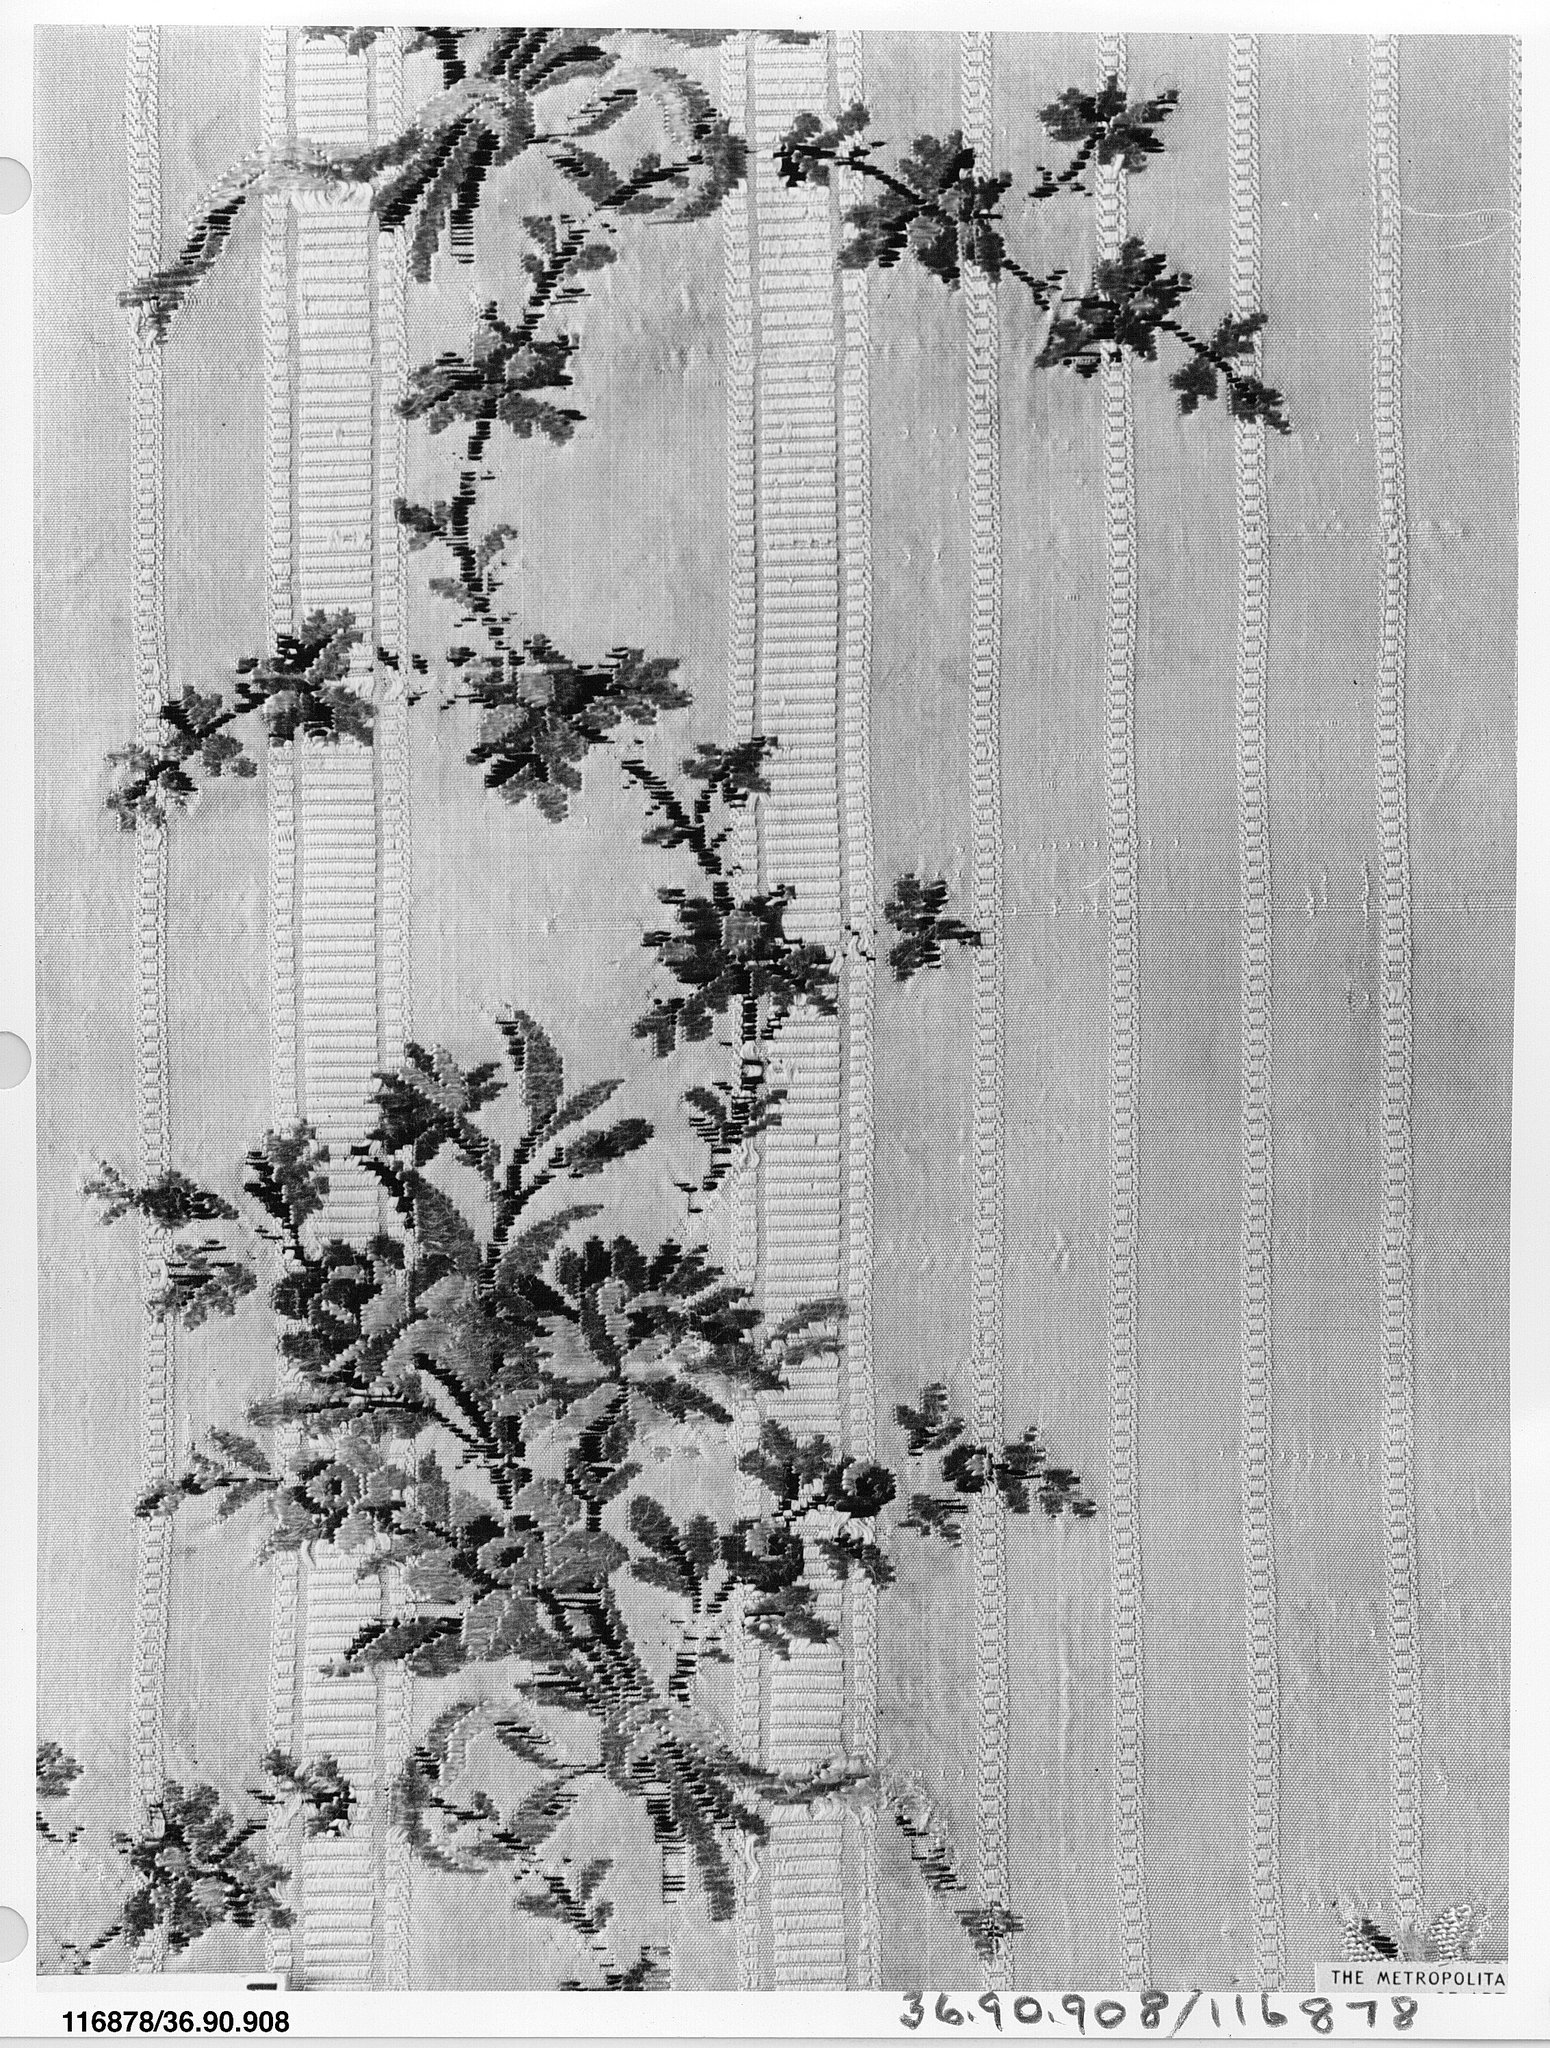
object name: piece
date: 1701-1800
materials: silk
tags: flowers,leaves